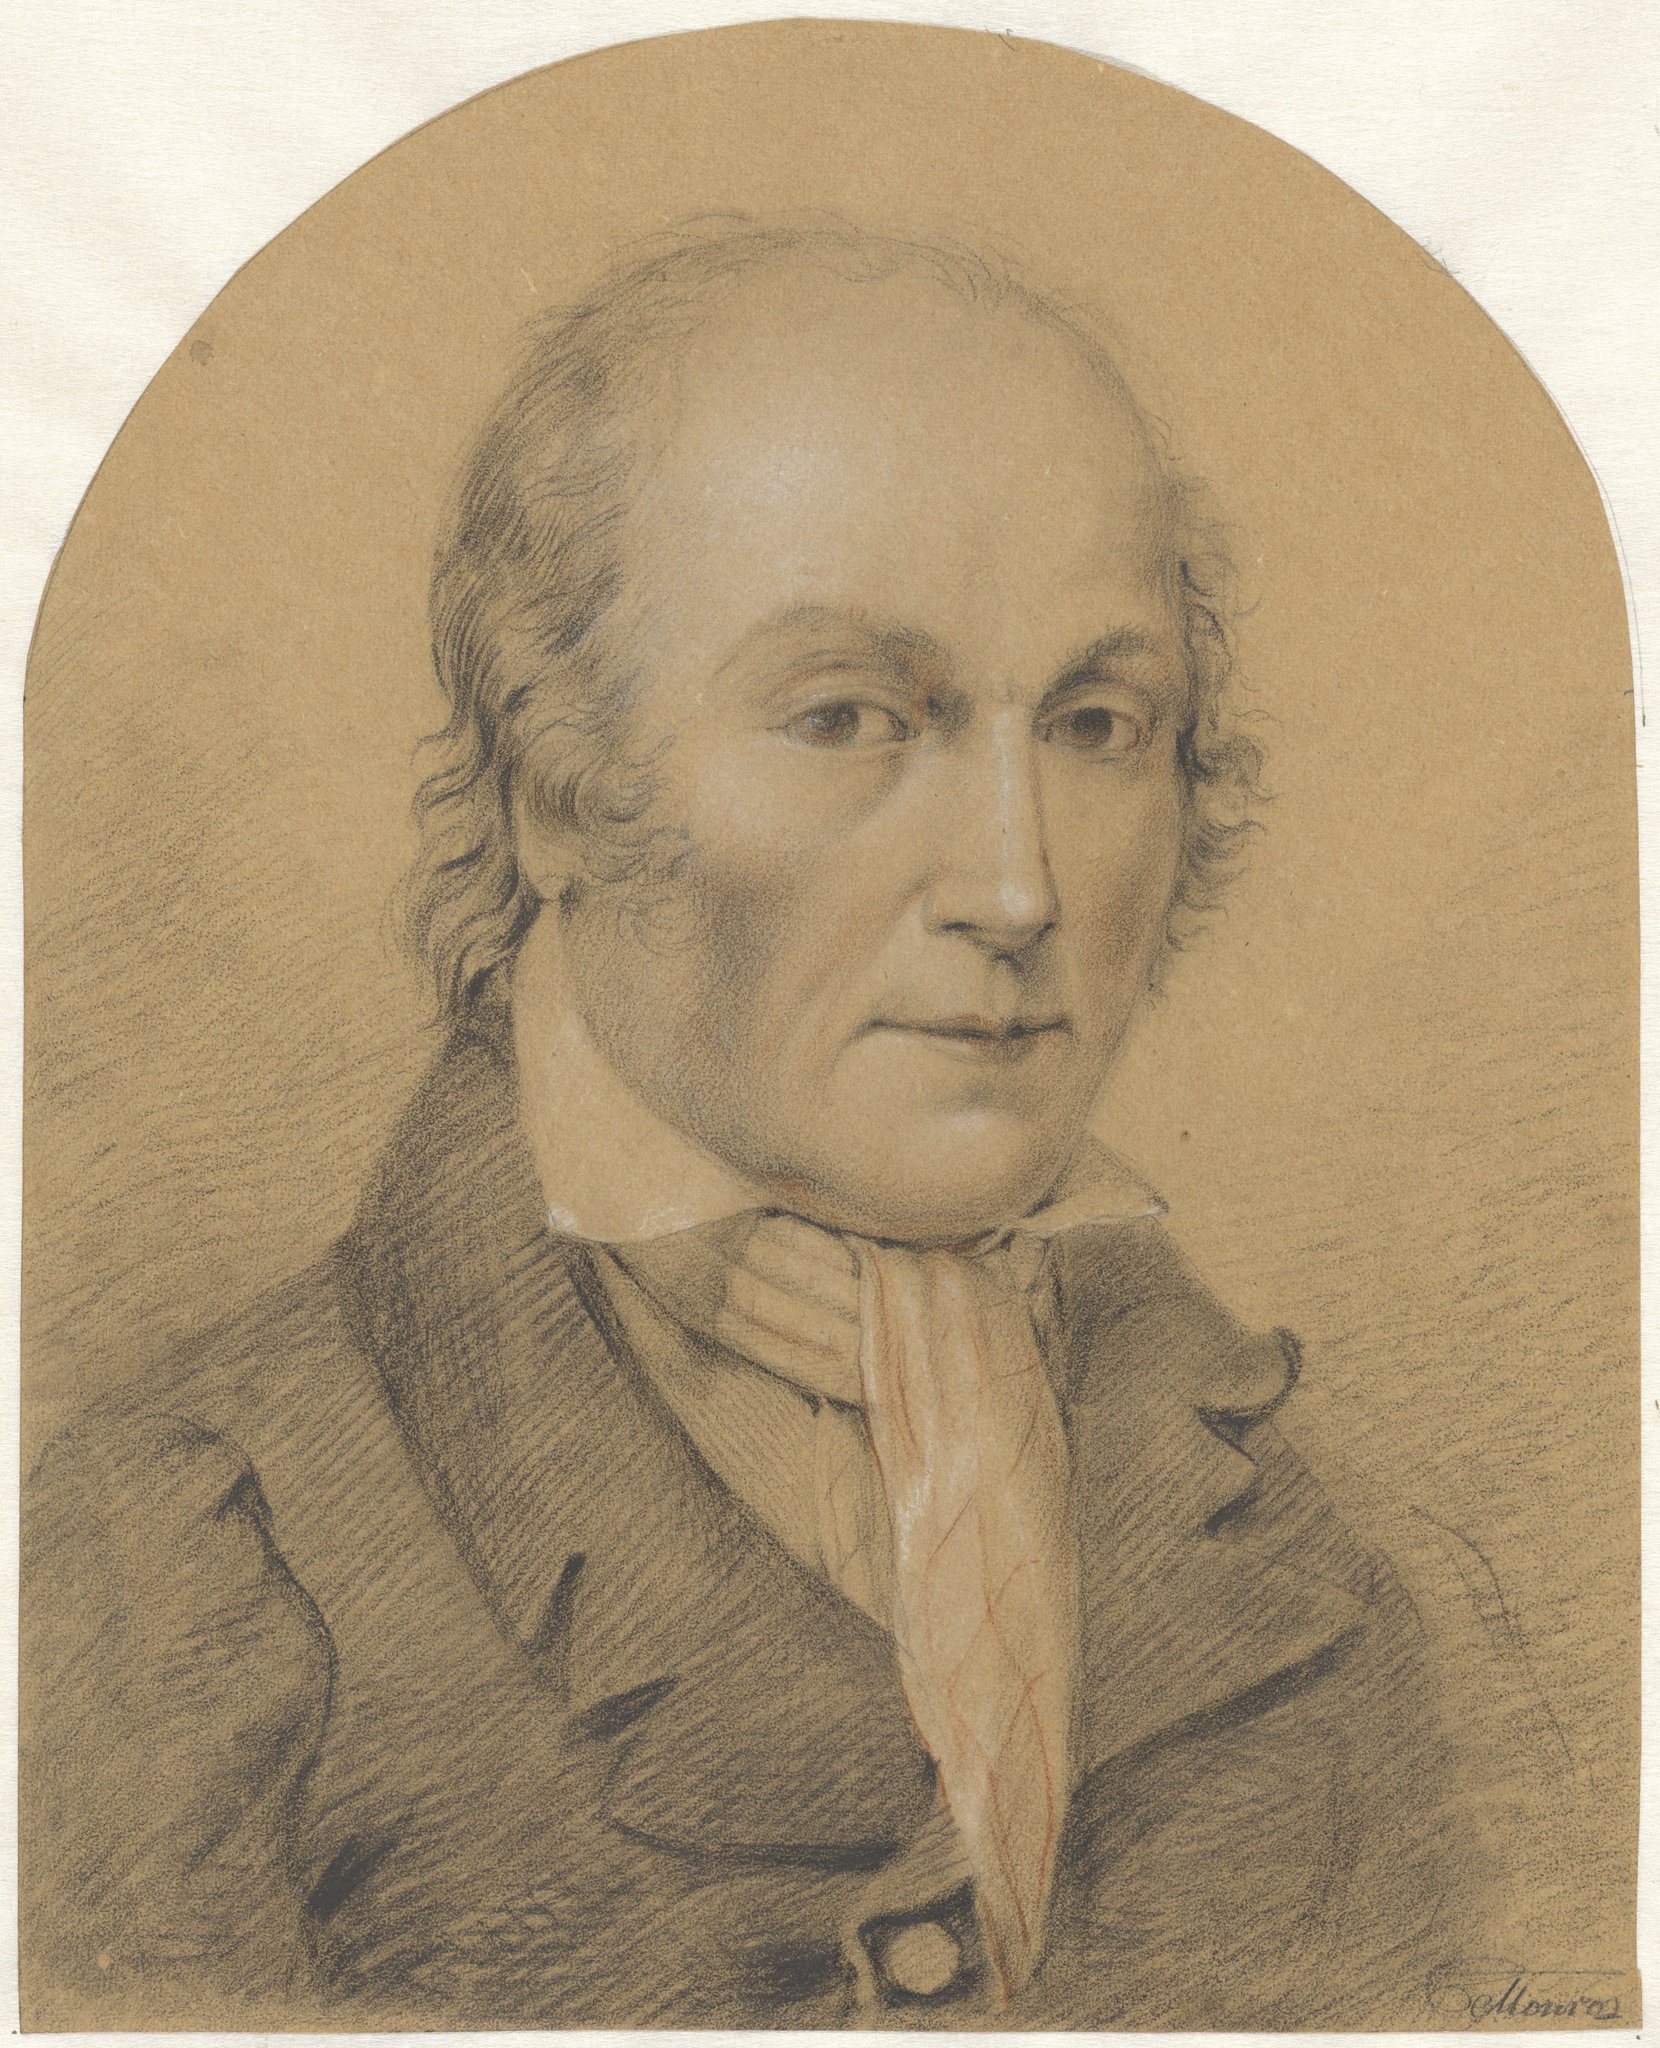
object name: drawing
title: Zelfportret van Jean François Michel Mourot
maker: michel mourot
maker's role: draughtsman, print maker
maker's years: 1803-1847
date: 1813-1847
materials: chalk, paper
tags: utrecht, print maker, michel mourot, historical persons, portrait, self-portrait of artist, portrait, self-portrait of draughtsman